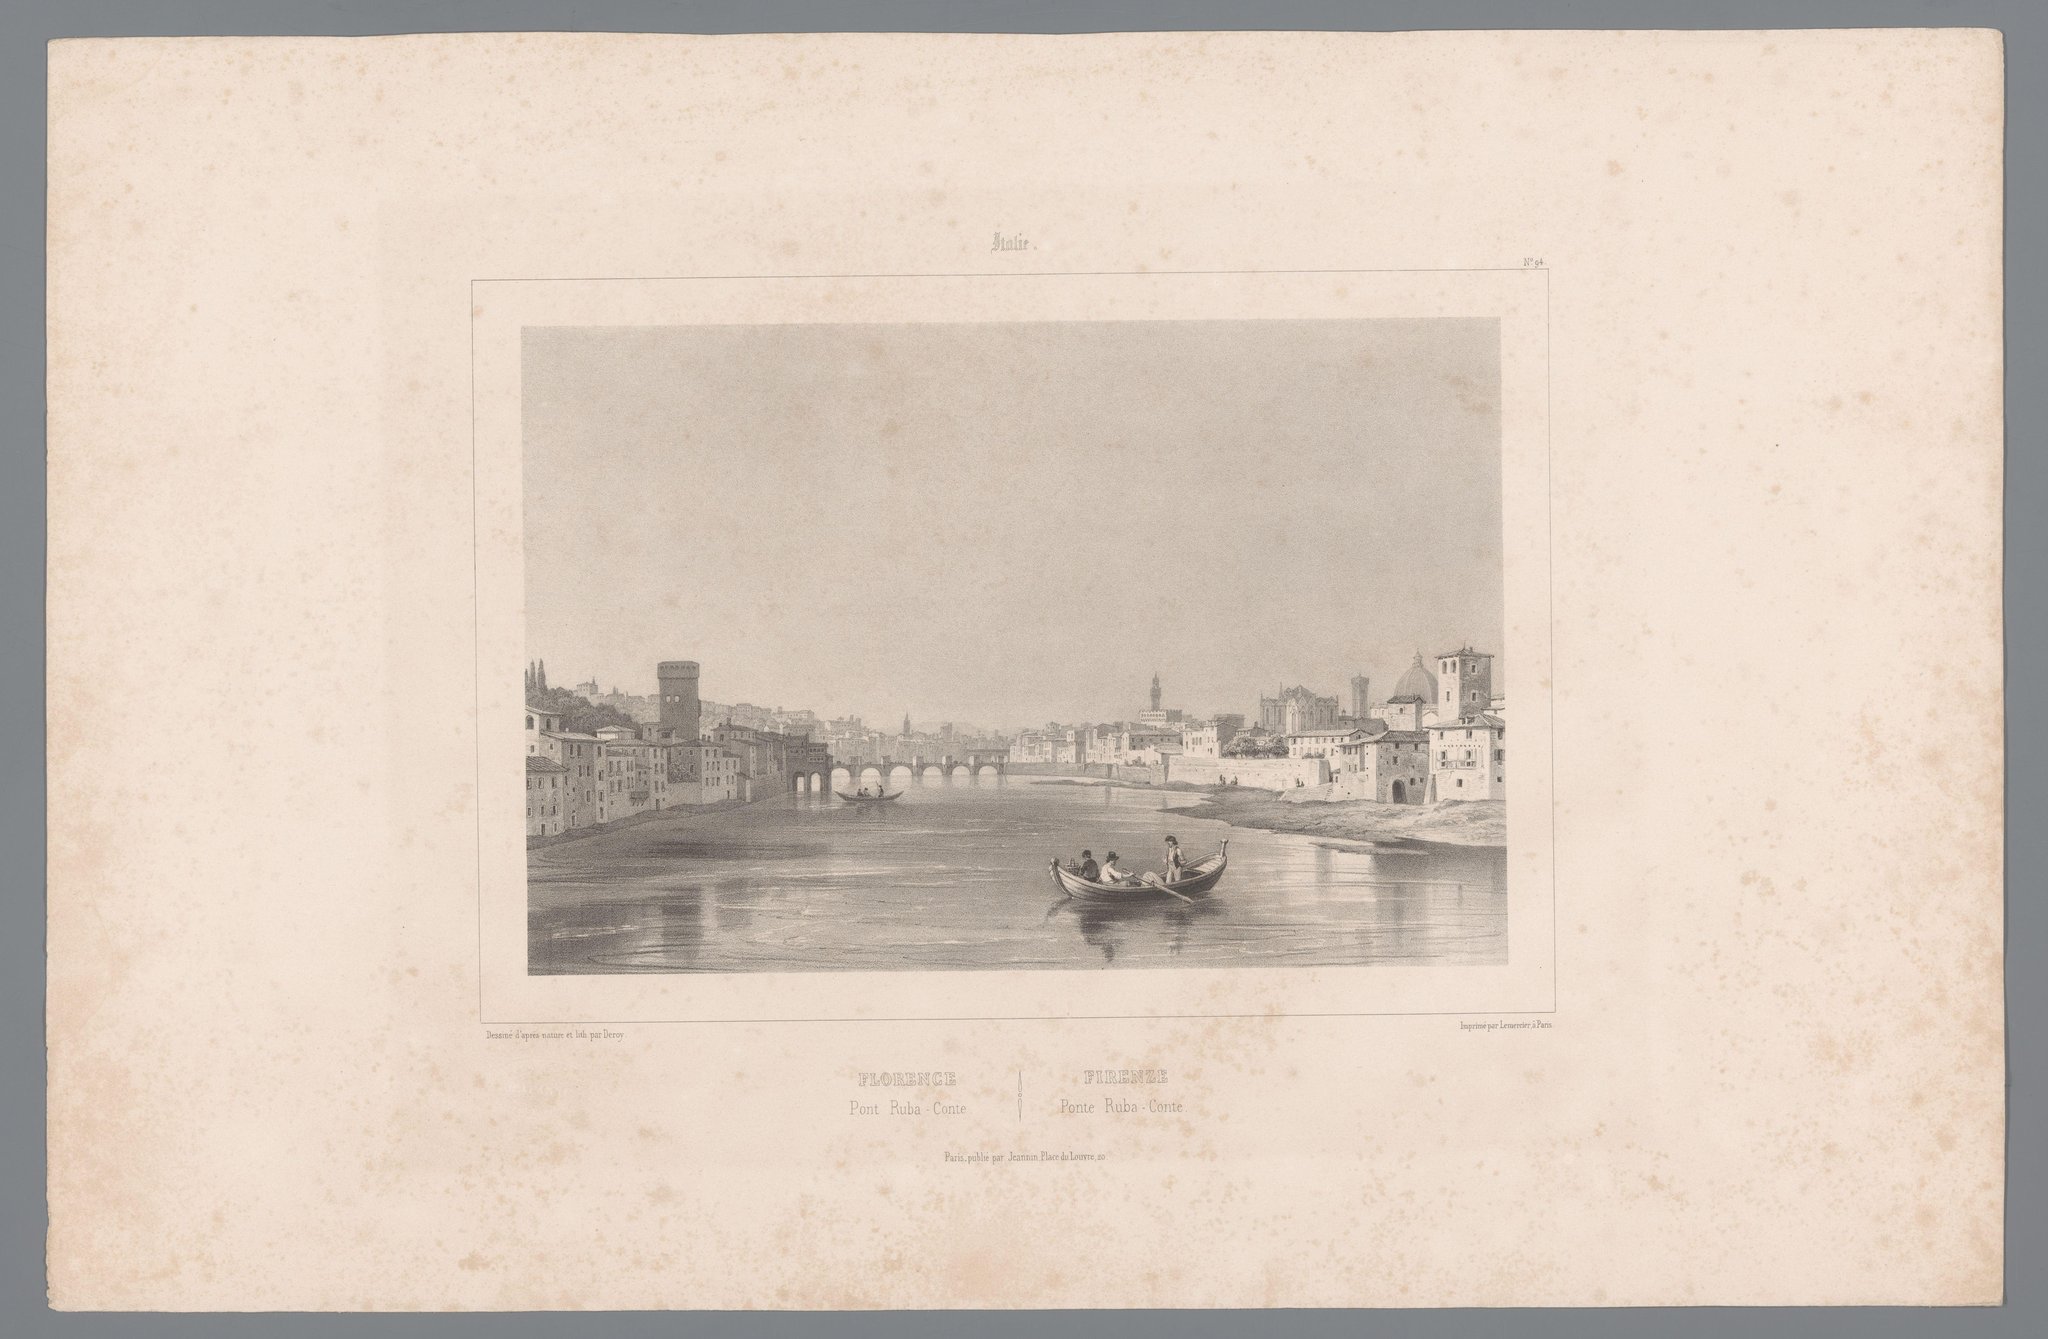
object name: print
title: Gezichten in Italië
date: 1843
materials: paper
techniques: lithograph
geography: paris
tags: bridge in city across river, canal, etc. (+ city(-scape) with figures, staffage), rowing-boat, canoe, etc.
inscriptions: collector's mark: Lugt 2228a, check stamp: Lugt 1397c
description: Prent maakt deel uit van een omslag met tien prenten.